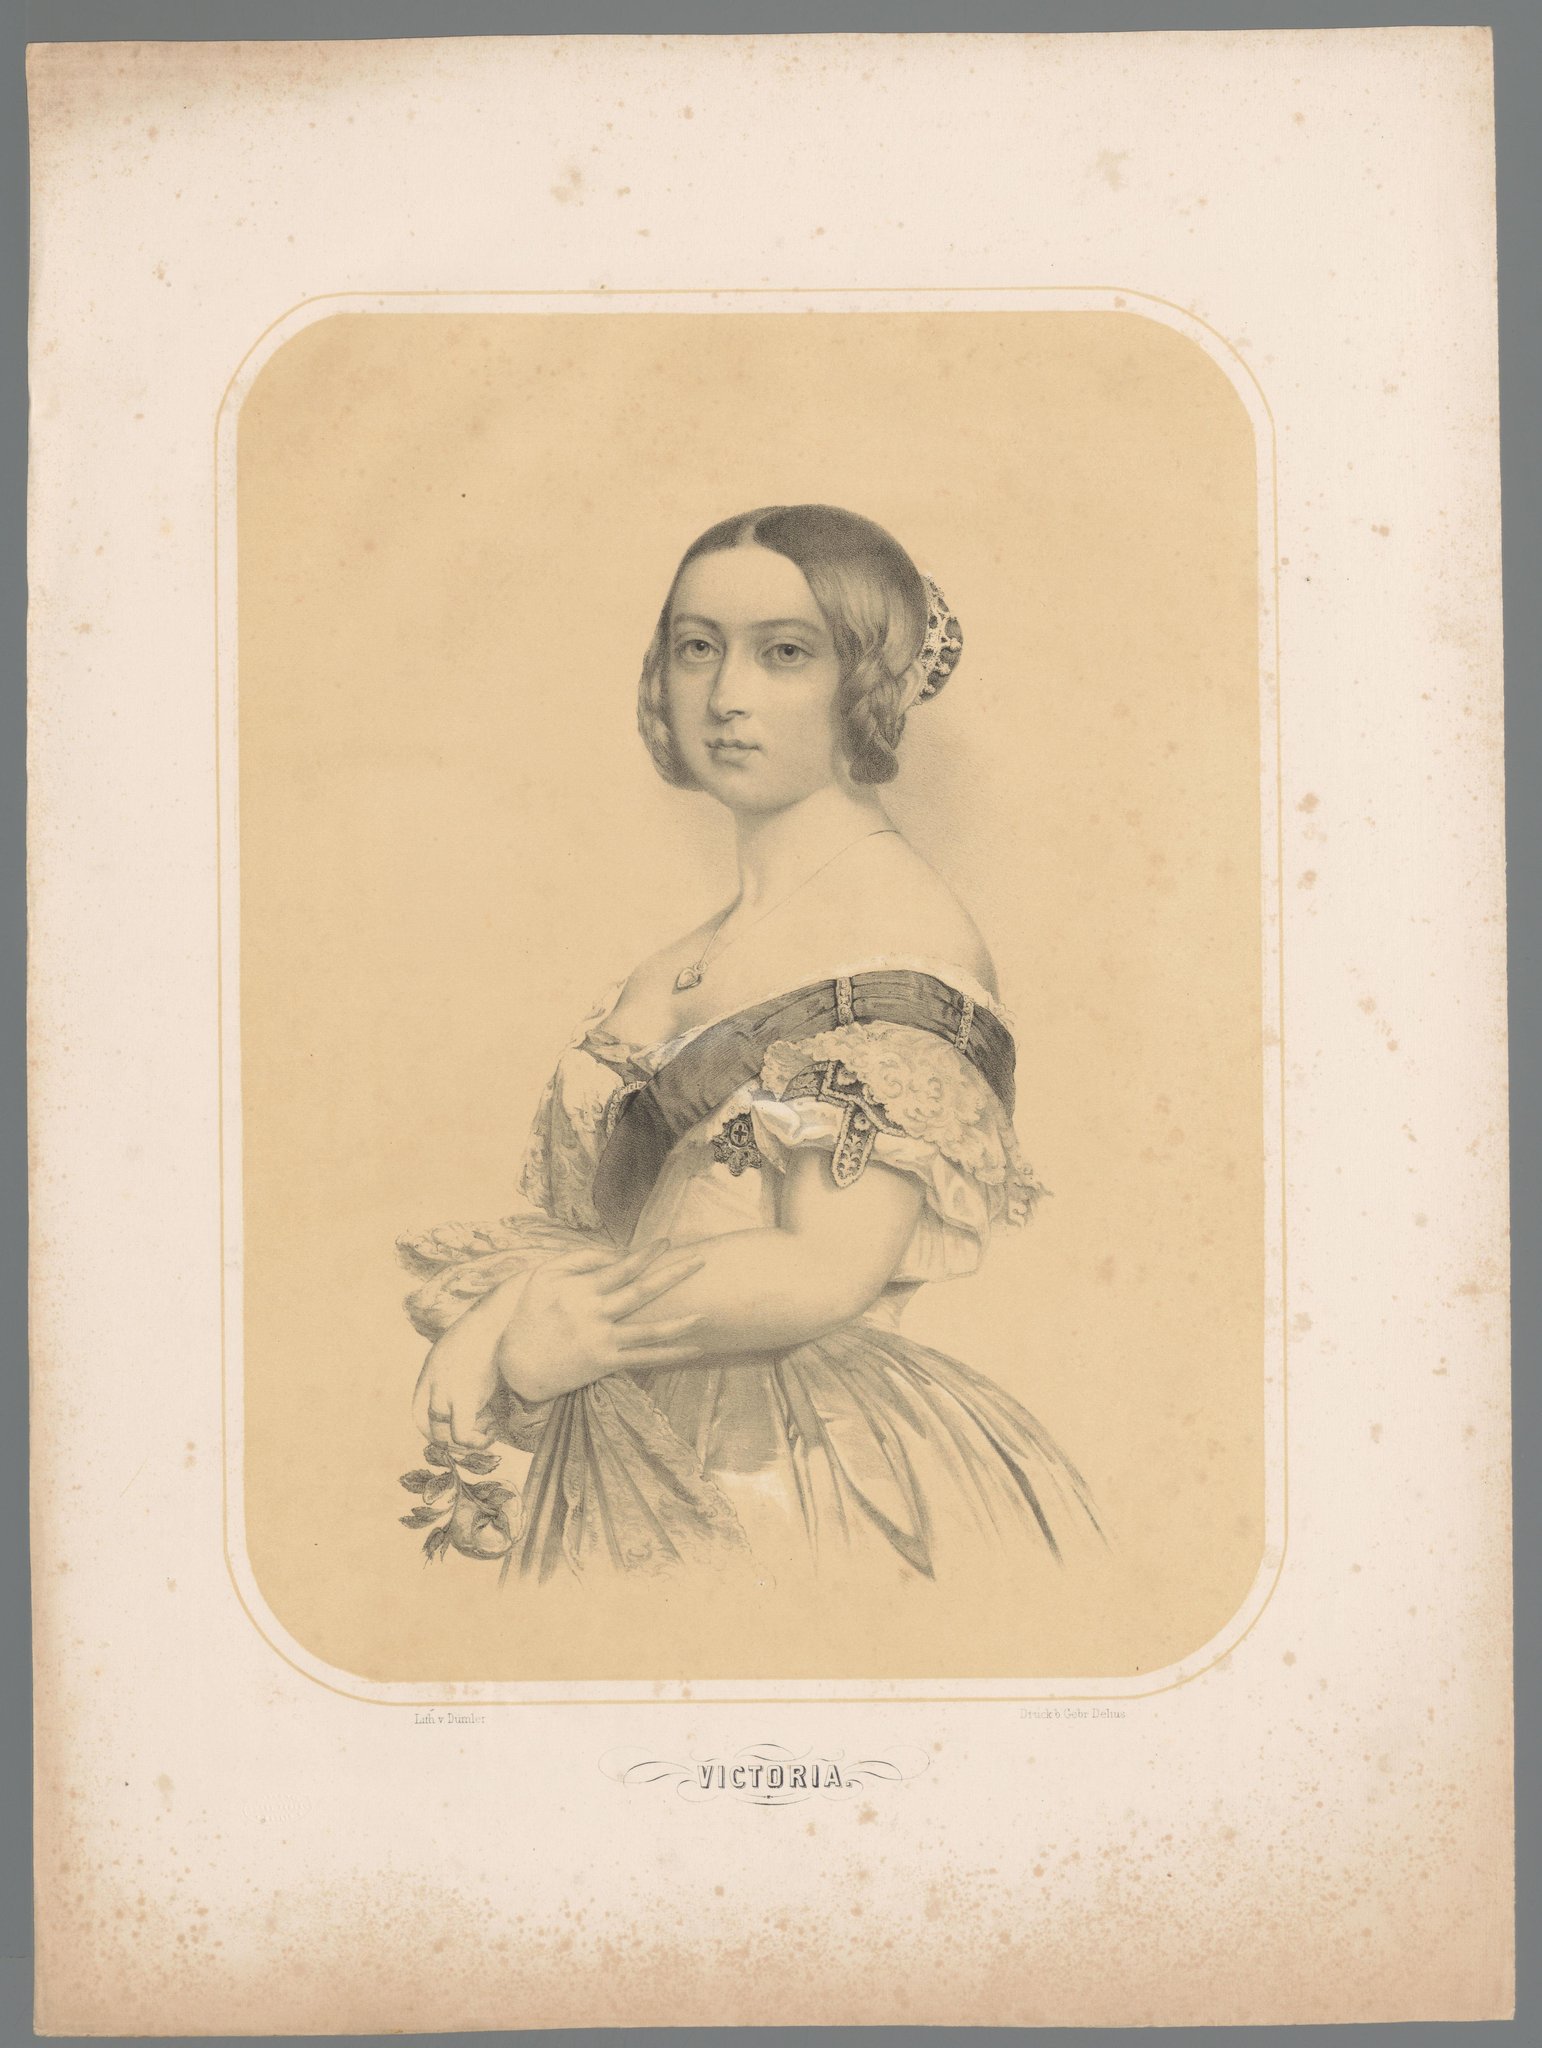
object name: print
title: Portret van koningin Victoria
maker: wilhelm dümler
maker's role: print maker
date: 1835-1850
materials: paper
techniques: tone lithography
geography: berlin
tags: victoria (koningin van het verenigd koninkrijk en keizerin van india), adolescent, young woman, maiden, historical persons, flowers: rose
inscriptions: check stamp: ‘F Sala&Co Kunst-Verlag Berlin’, collector's mark: Lugt 2228